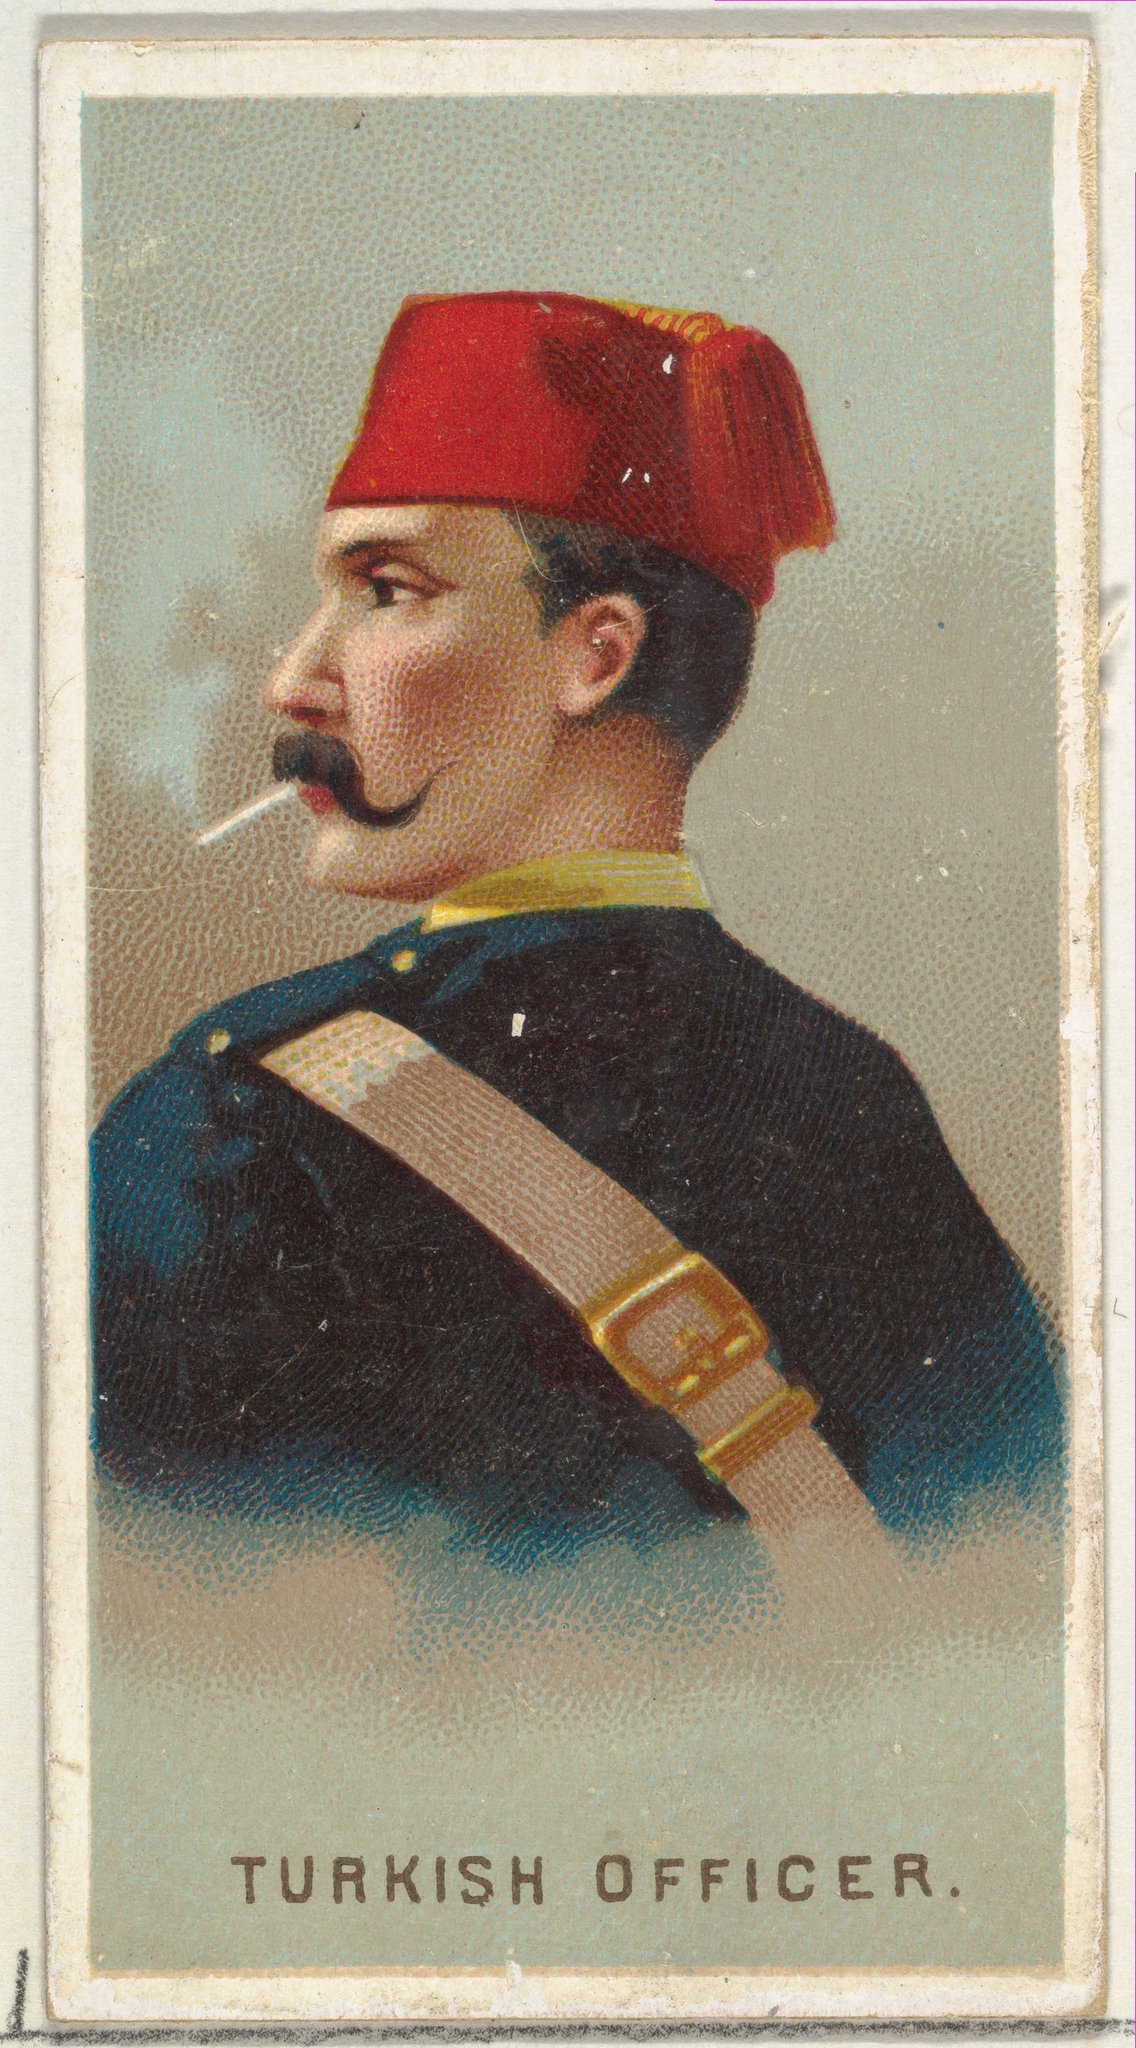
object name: print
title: Turkish Officer, from World's Smokers series (N33) for Allen & Ginter Cigarettes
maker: allen & ginter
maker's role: publisher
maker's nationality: american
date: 1888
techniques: color lithograph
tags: men,profiles,smoking